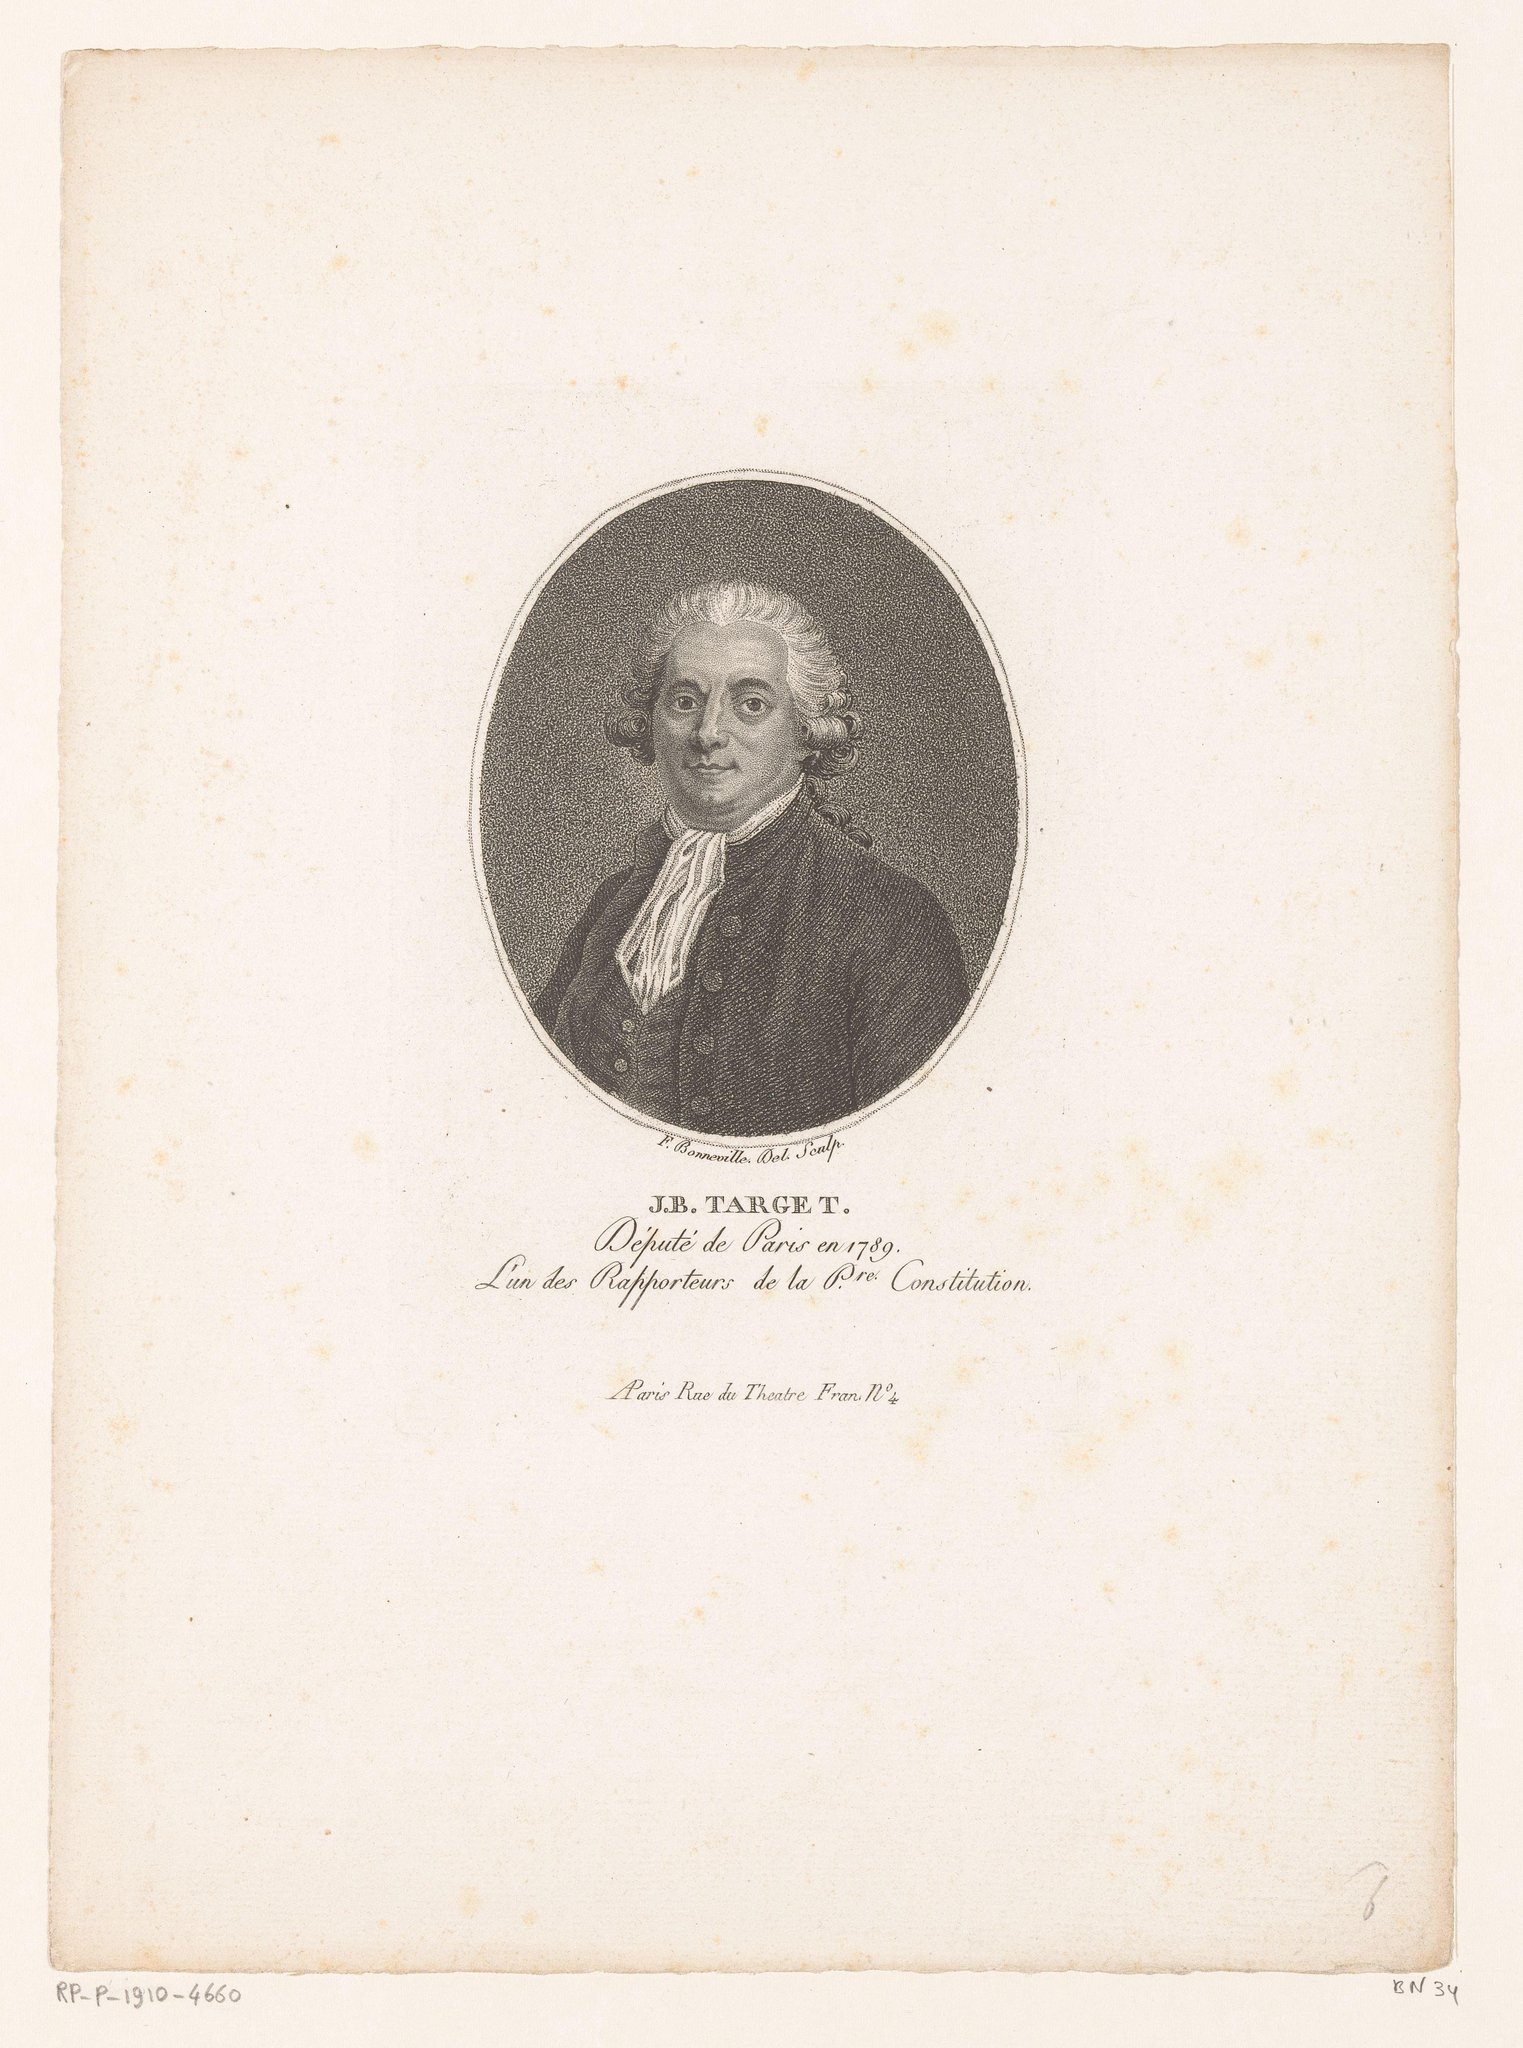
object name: print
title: Portraits des personnages célèbres de la Révolution (...)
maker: françois bonneville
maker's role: draughtsman, painter, print maker, publisher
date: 1796-1802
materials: paper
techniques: engraving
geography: paris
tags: historical persons, lawyer, attorney at law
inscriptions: collector's mark: Lugt 2228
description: Maakt deel uit van een serie getiteld: Portraits des personnages célèbres de la Révolution (...), uitgegeven tussen 1796-1802.